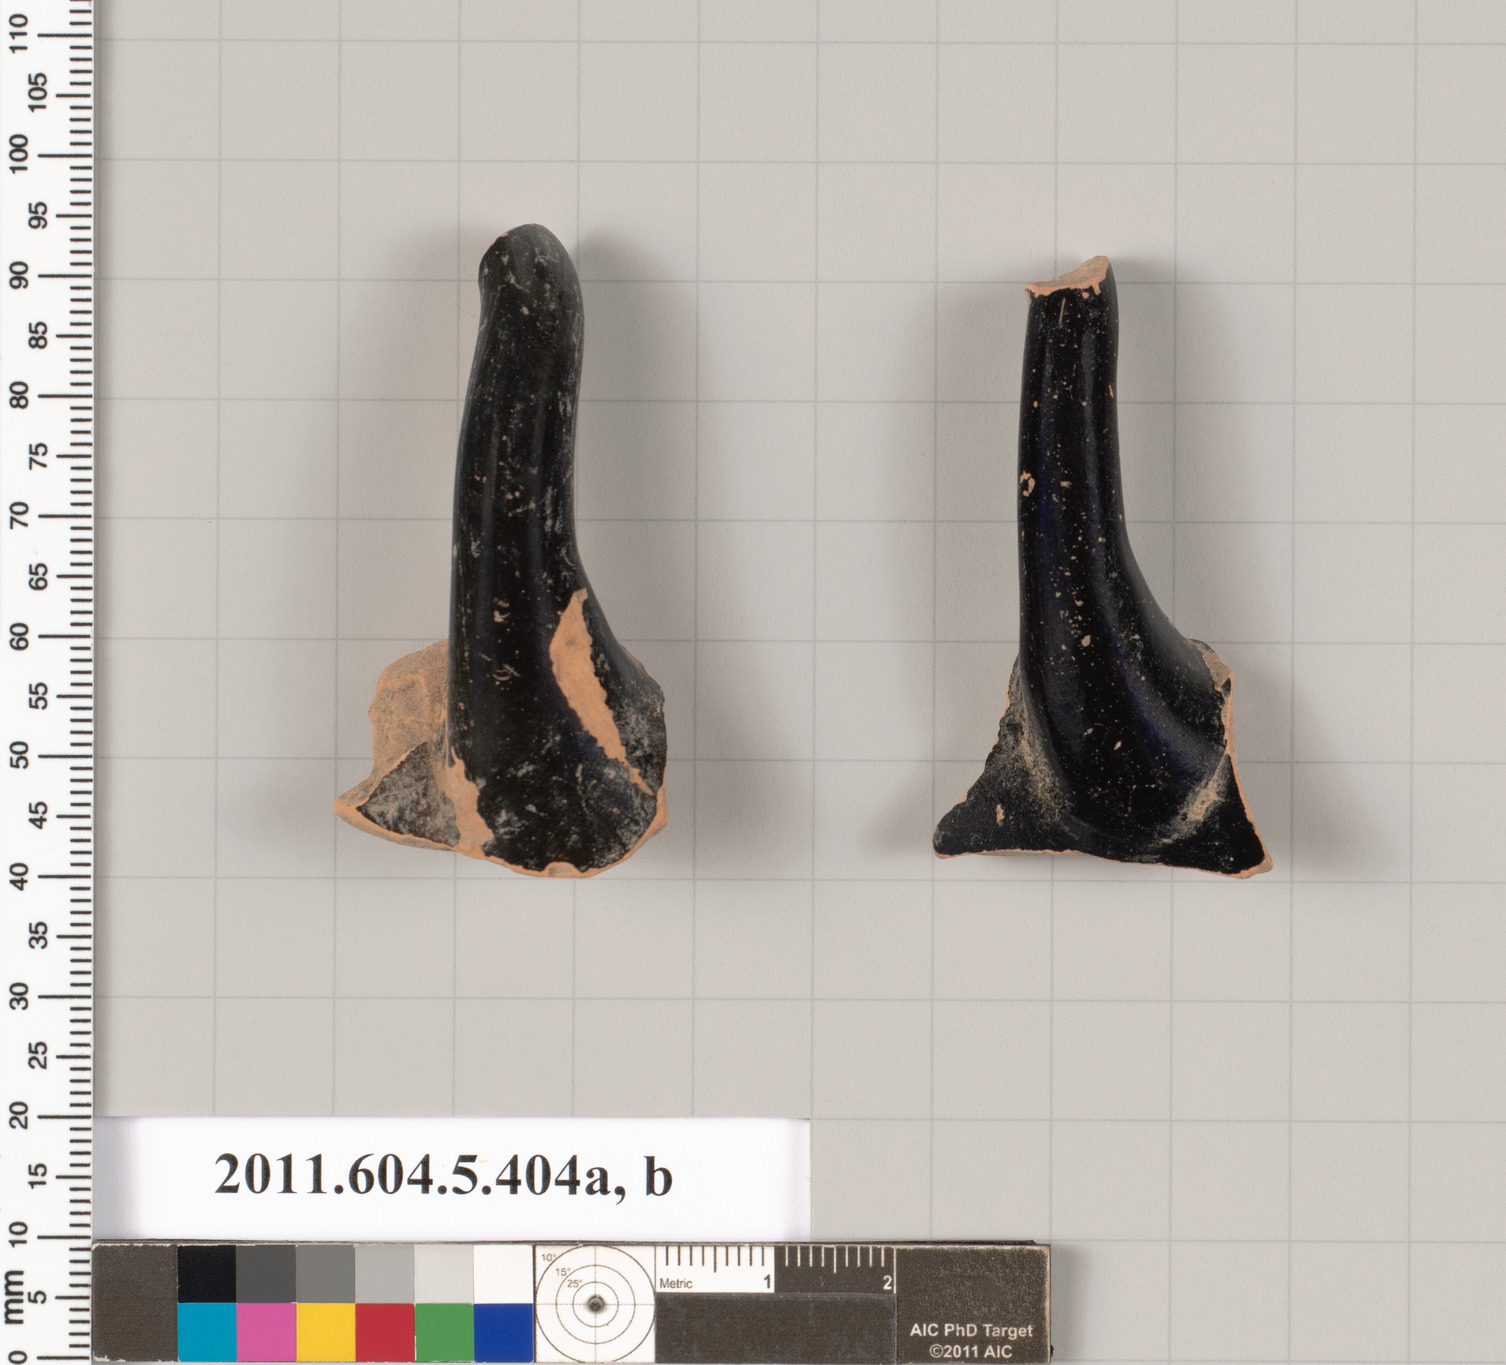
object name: kylix fragment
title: Terracotta fragments of kylikes (drinking cups)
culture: greek, attic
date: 600-401 BCE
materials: terracotta